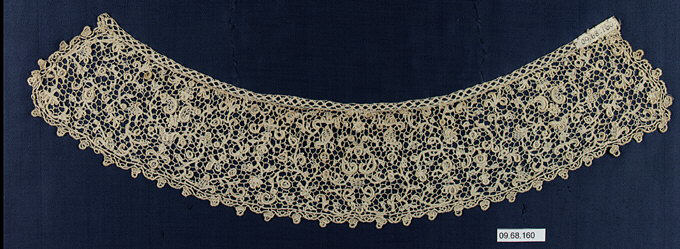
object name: collar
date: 1667-1700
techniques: lace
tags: flowers